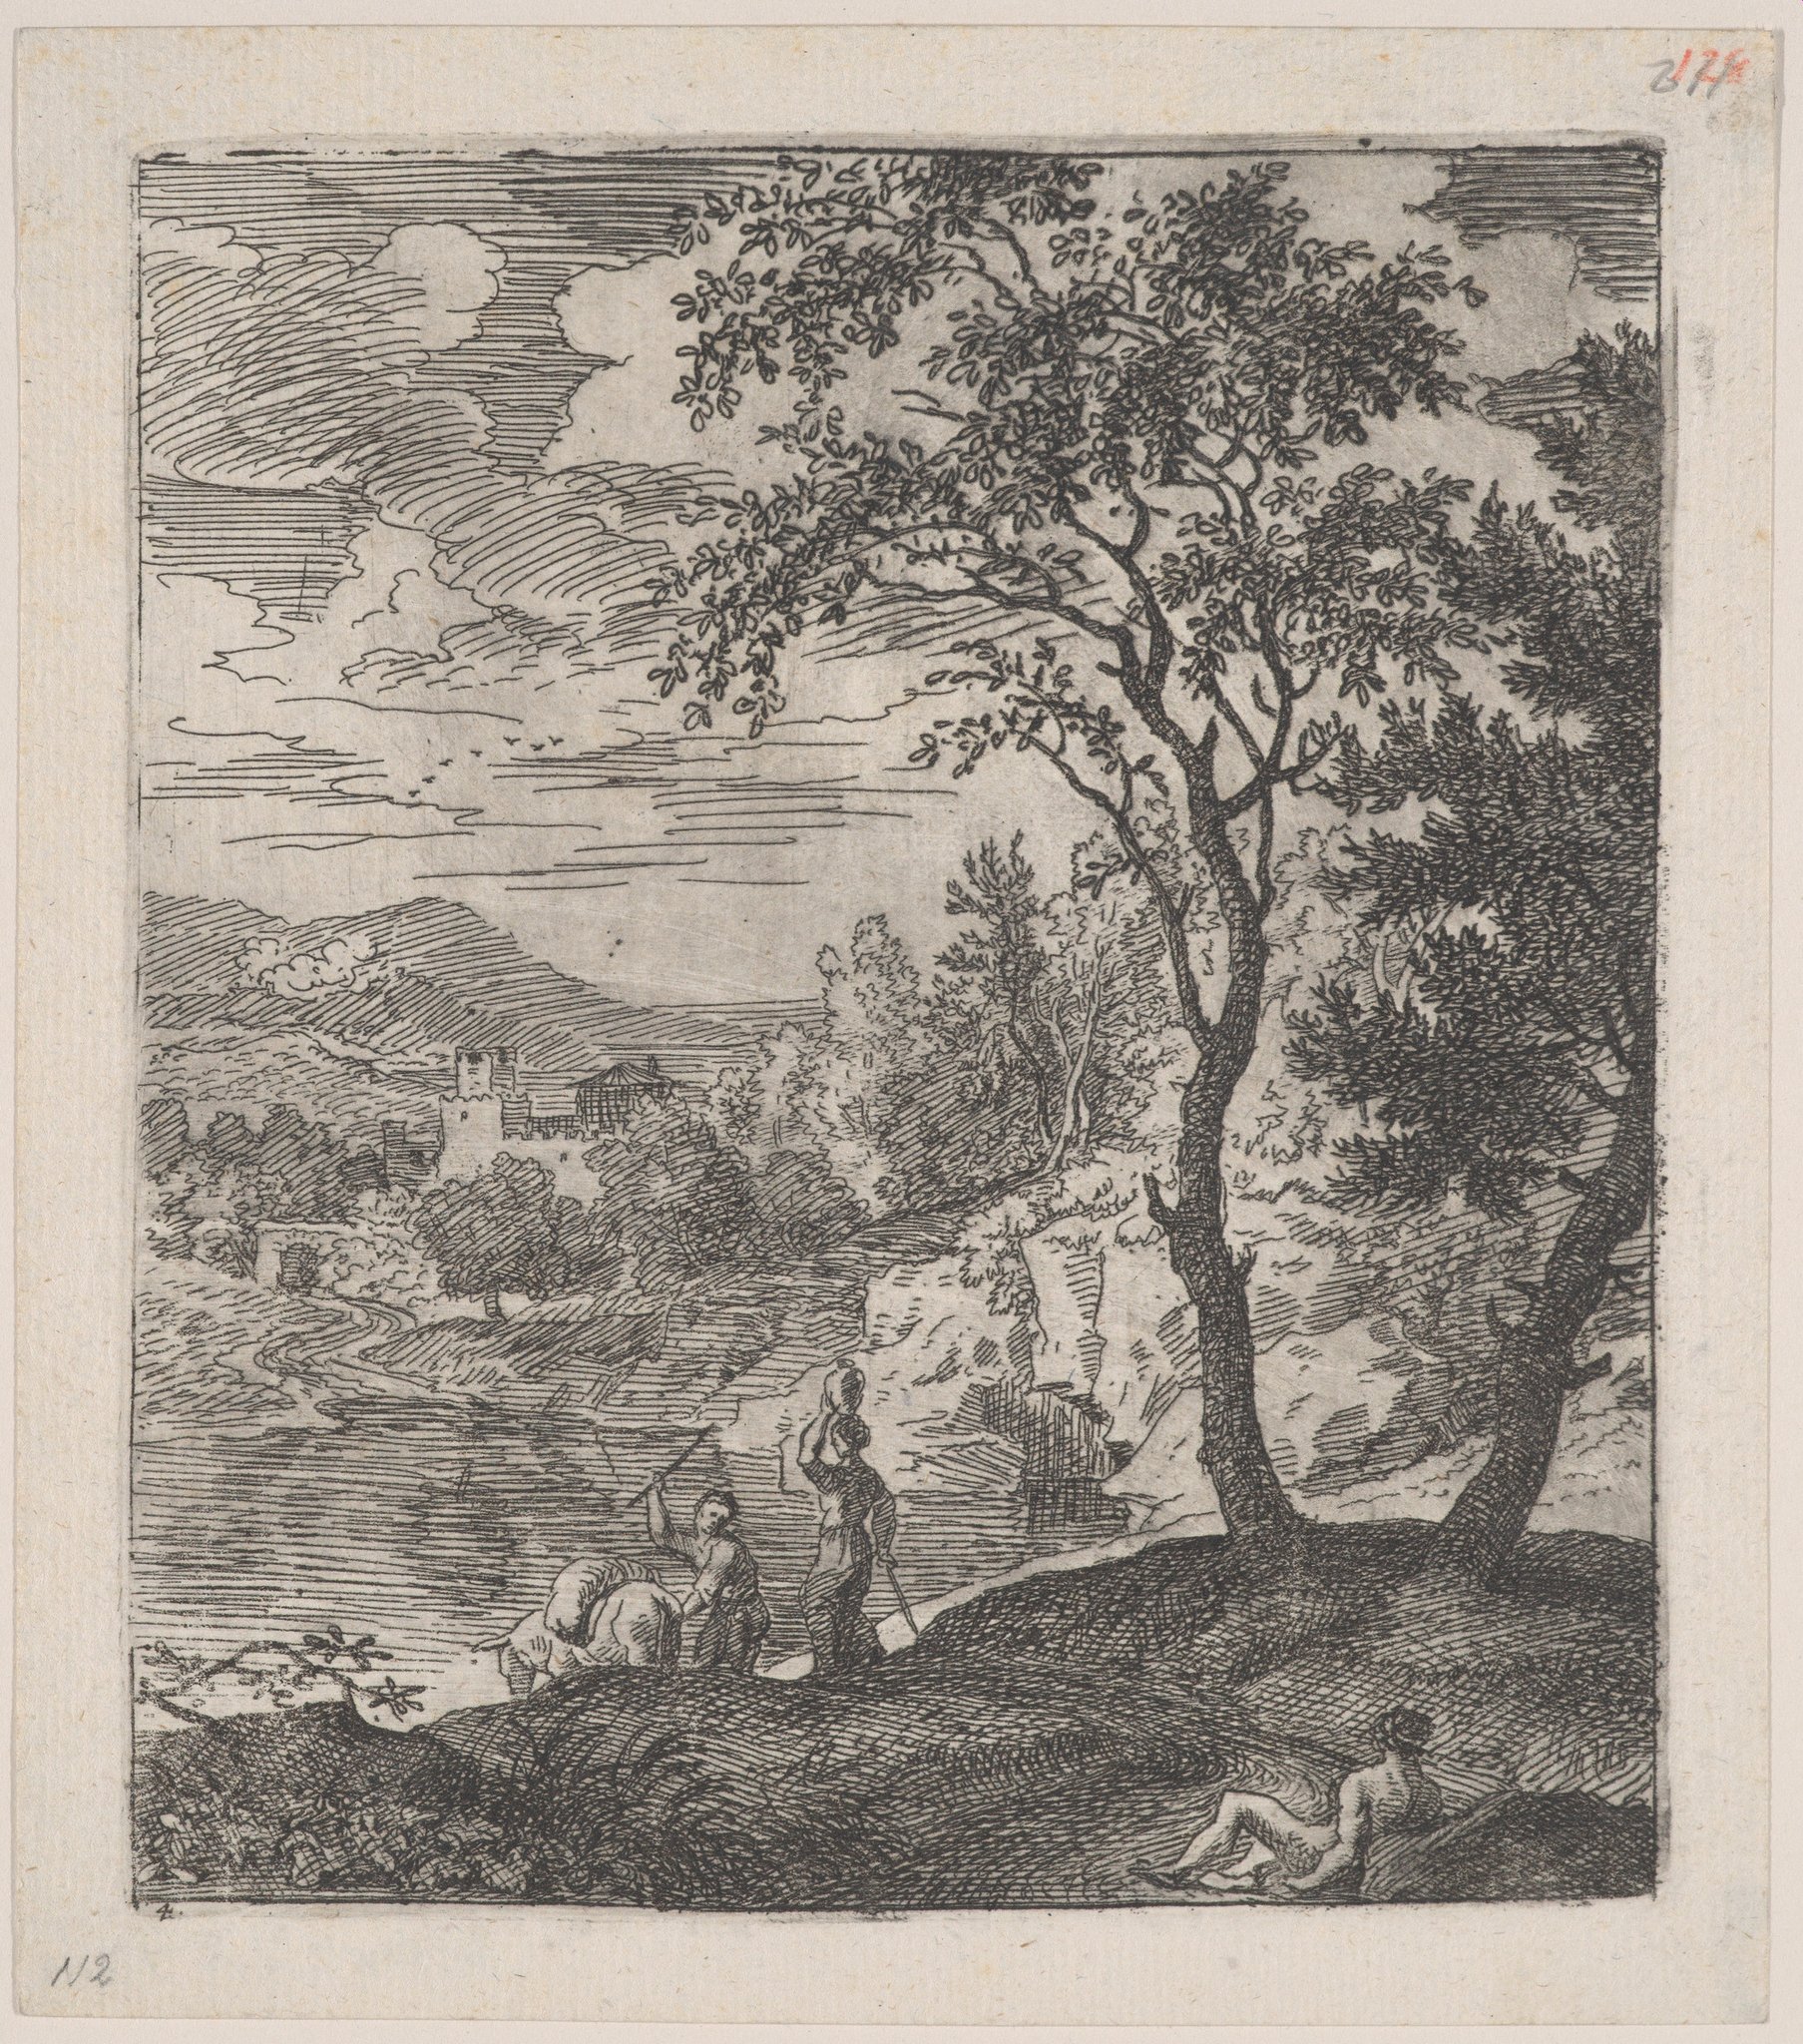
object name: print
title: Plate 4: a peasant with a donkey on a riverbank, a woman walking towards him with a vase on her head, and a reclining figure at right in the foreground, from 'Landscapes in the manner of Gaspar Dughet'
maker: franz joachim beich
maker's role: artist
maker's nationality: german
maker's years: 1665-1745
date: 1700-1725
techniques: etching